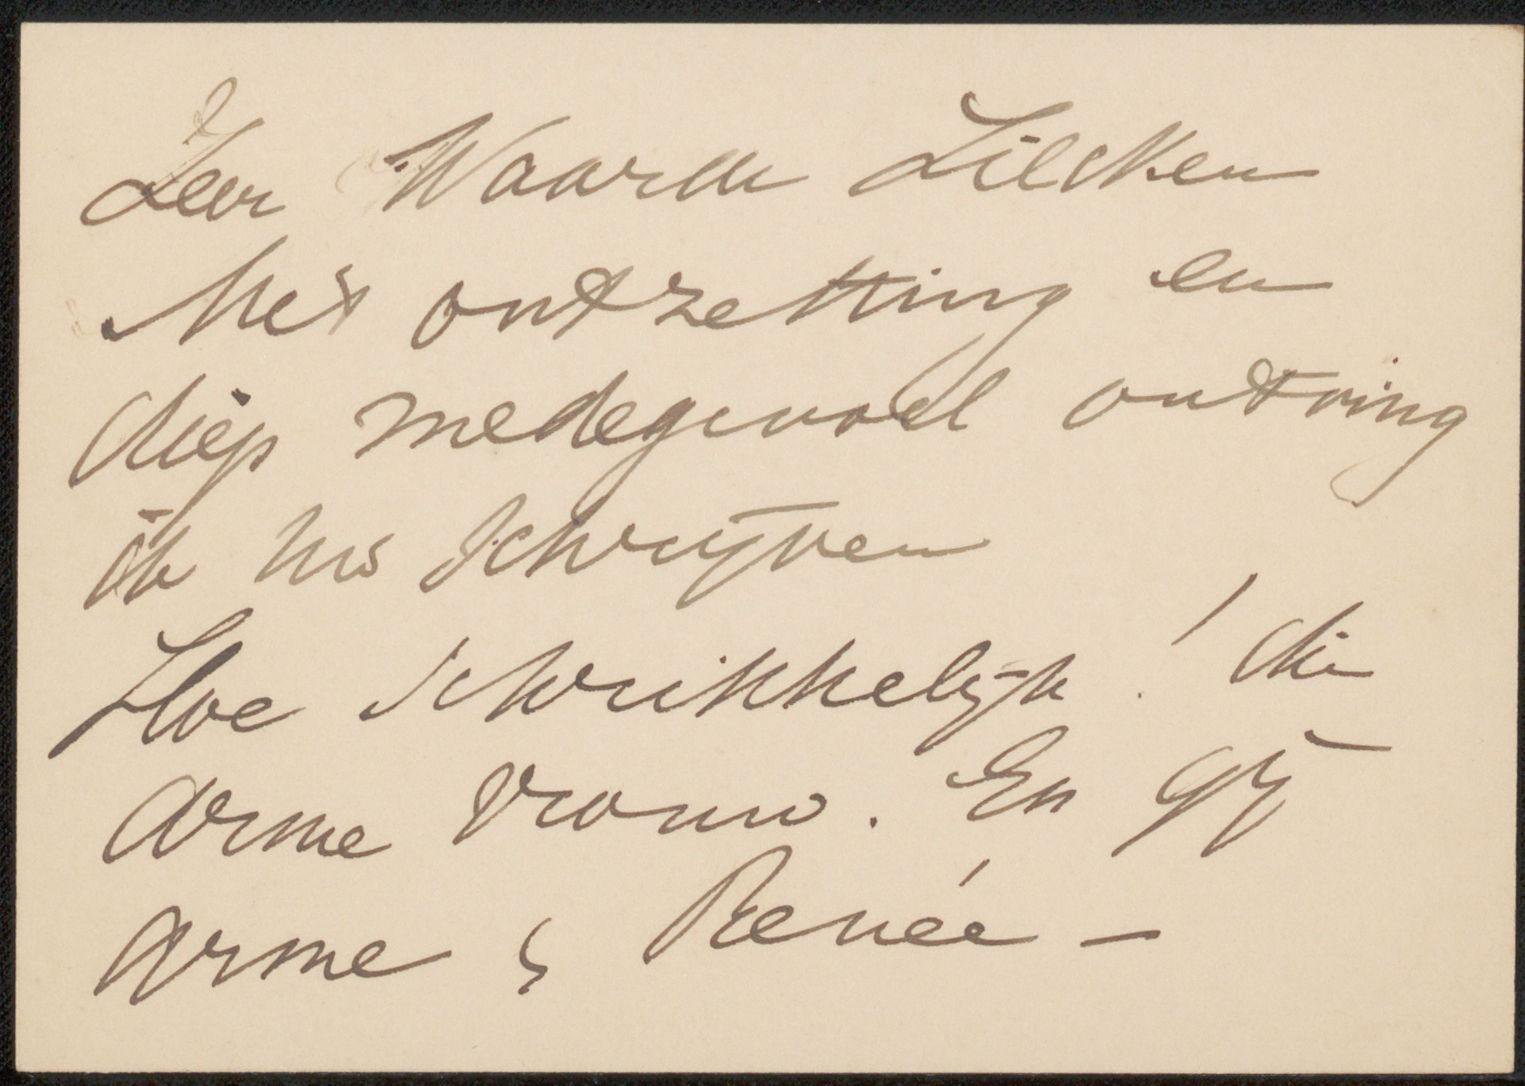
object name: letter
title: Brief aan Philip Zilcken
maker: saar de swart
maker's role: sculptor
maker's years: 1861-1951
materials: ink, paper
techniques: pen, writing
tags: voorburg, renée hélène laure zilcken, brussels, helène lambertine hauzeur, painter, draughtsman, philip zilcken, passions, emotions, affections, christian religion